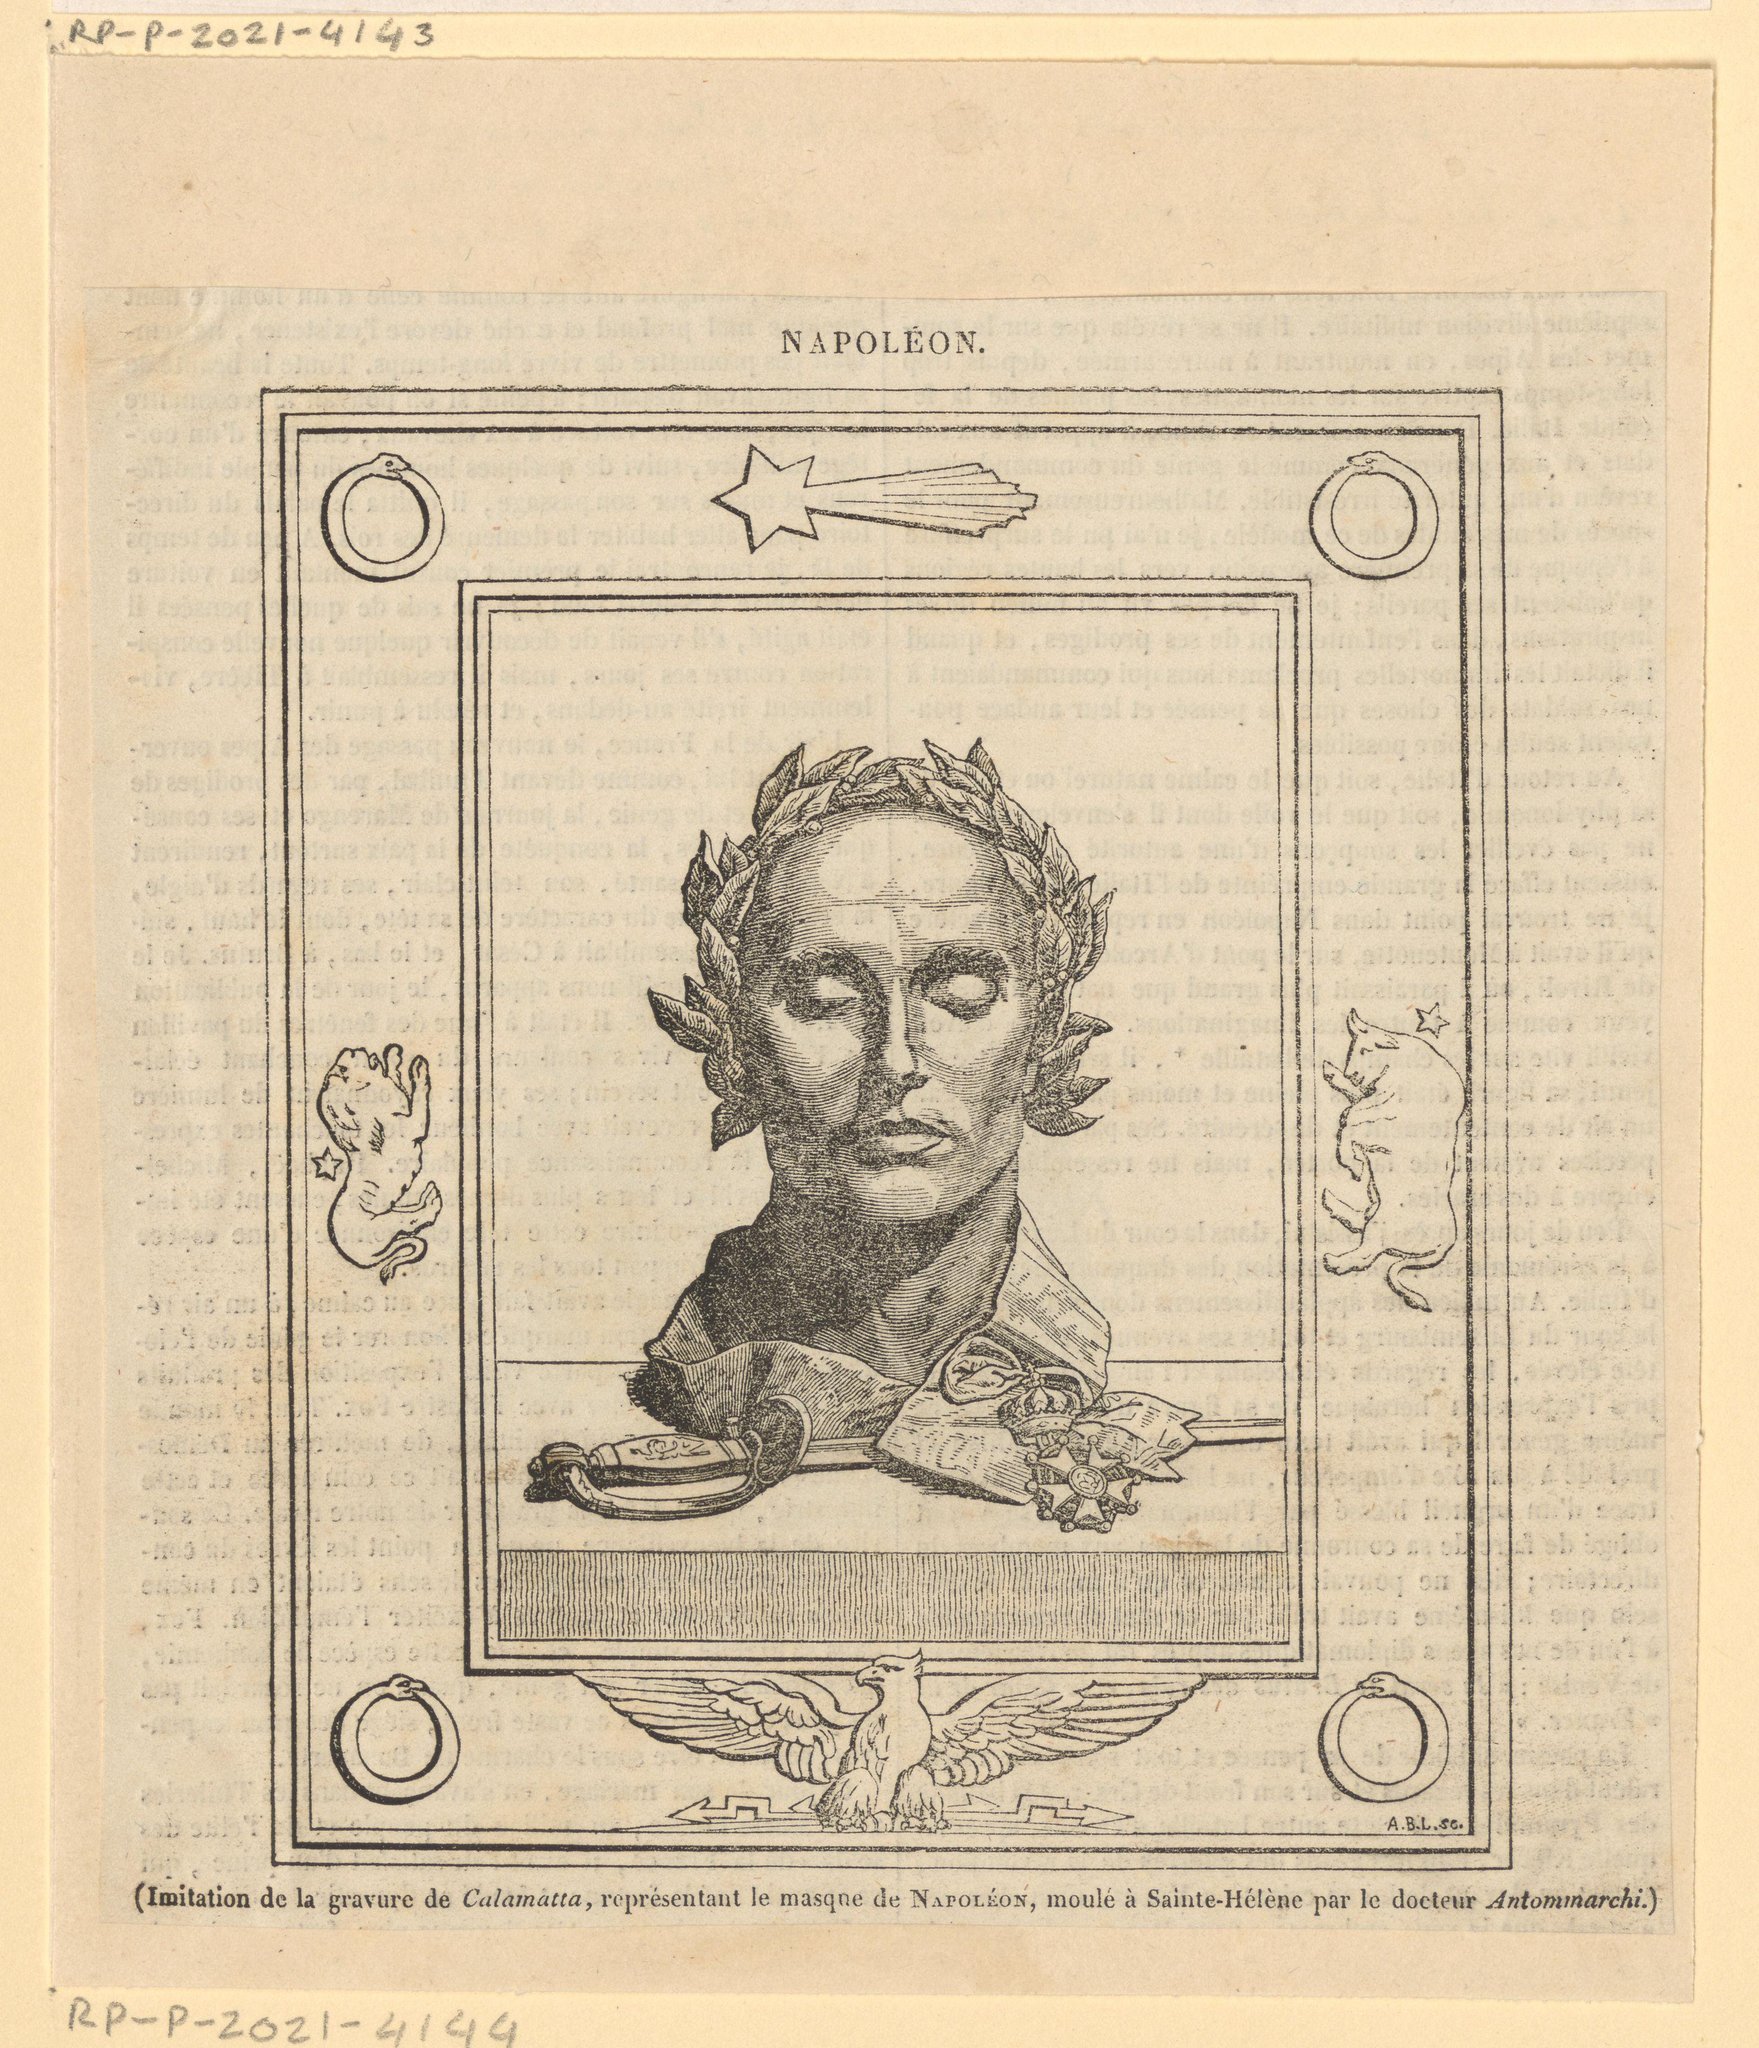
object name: print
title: Doodsportret van Napoleon I Bonaparte, keizer van Frankrijk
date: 1834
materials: paper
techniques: letterpress printing, engraving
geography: paris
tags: napoleon i (emperor of the french), death-mask, historical persons, emperor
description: Prent uit: Le Magasin pittoresque 2 (1834).